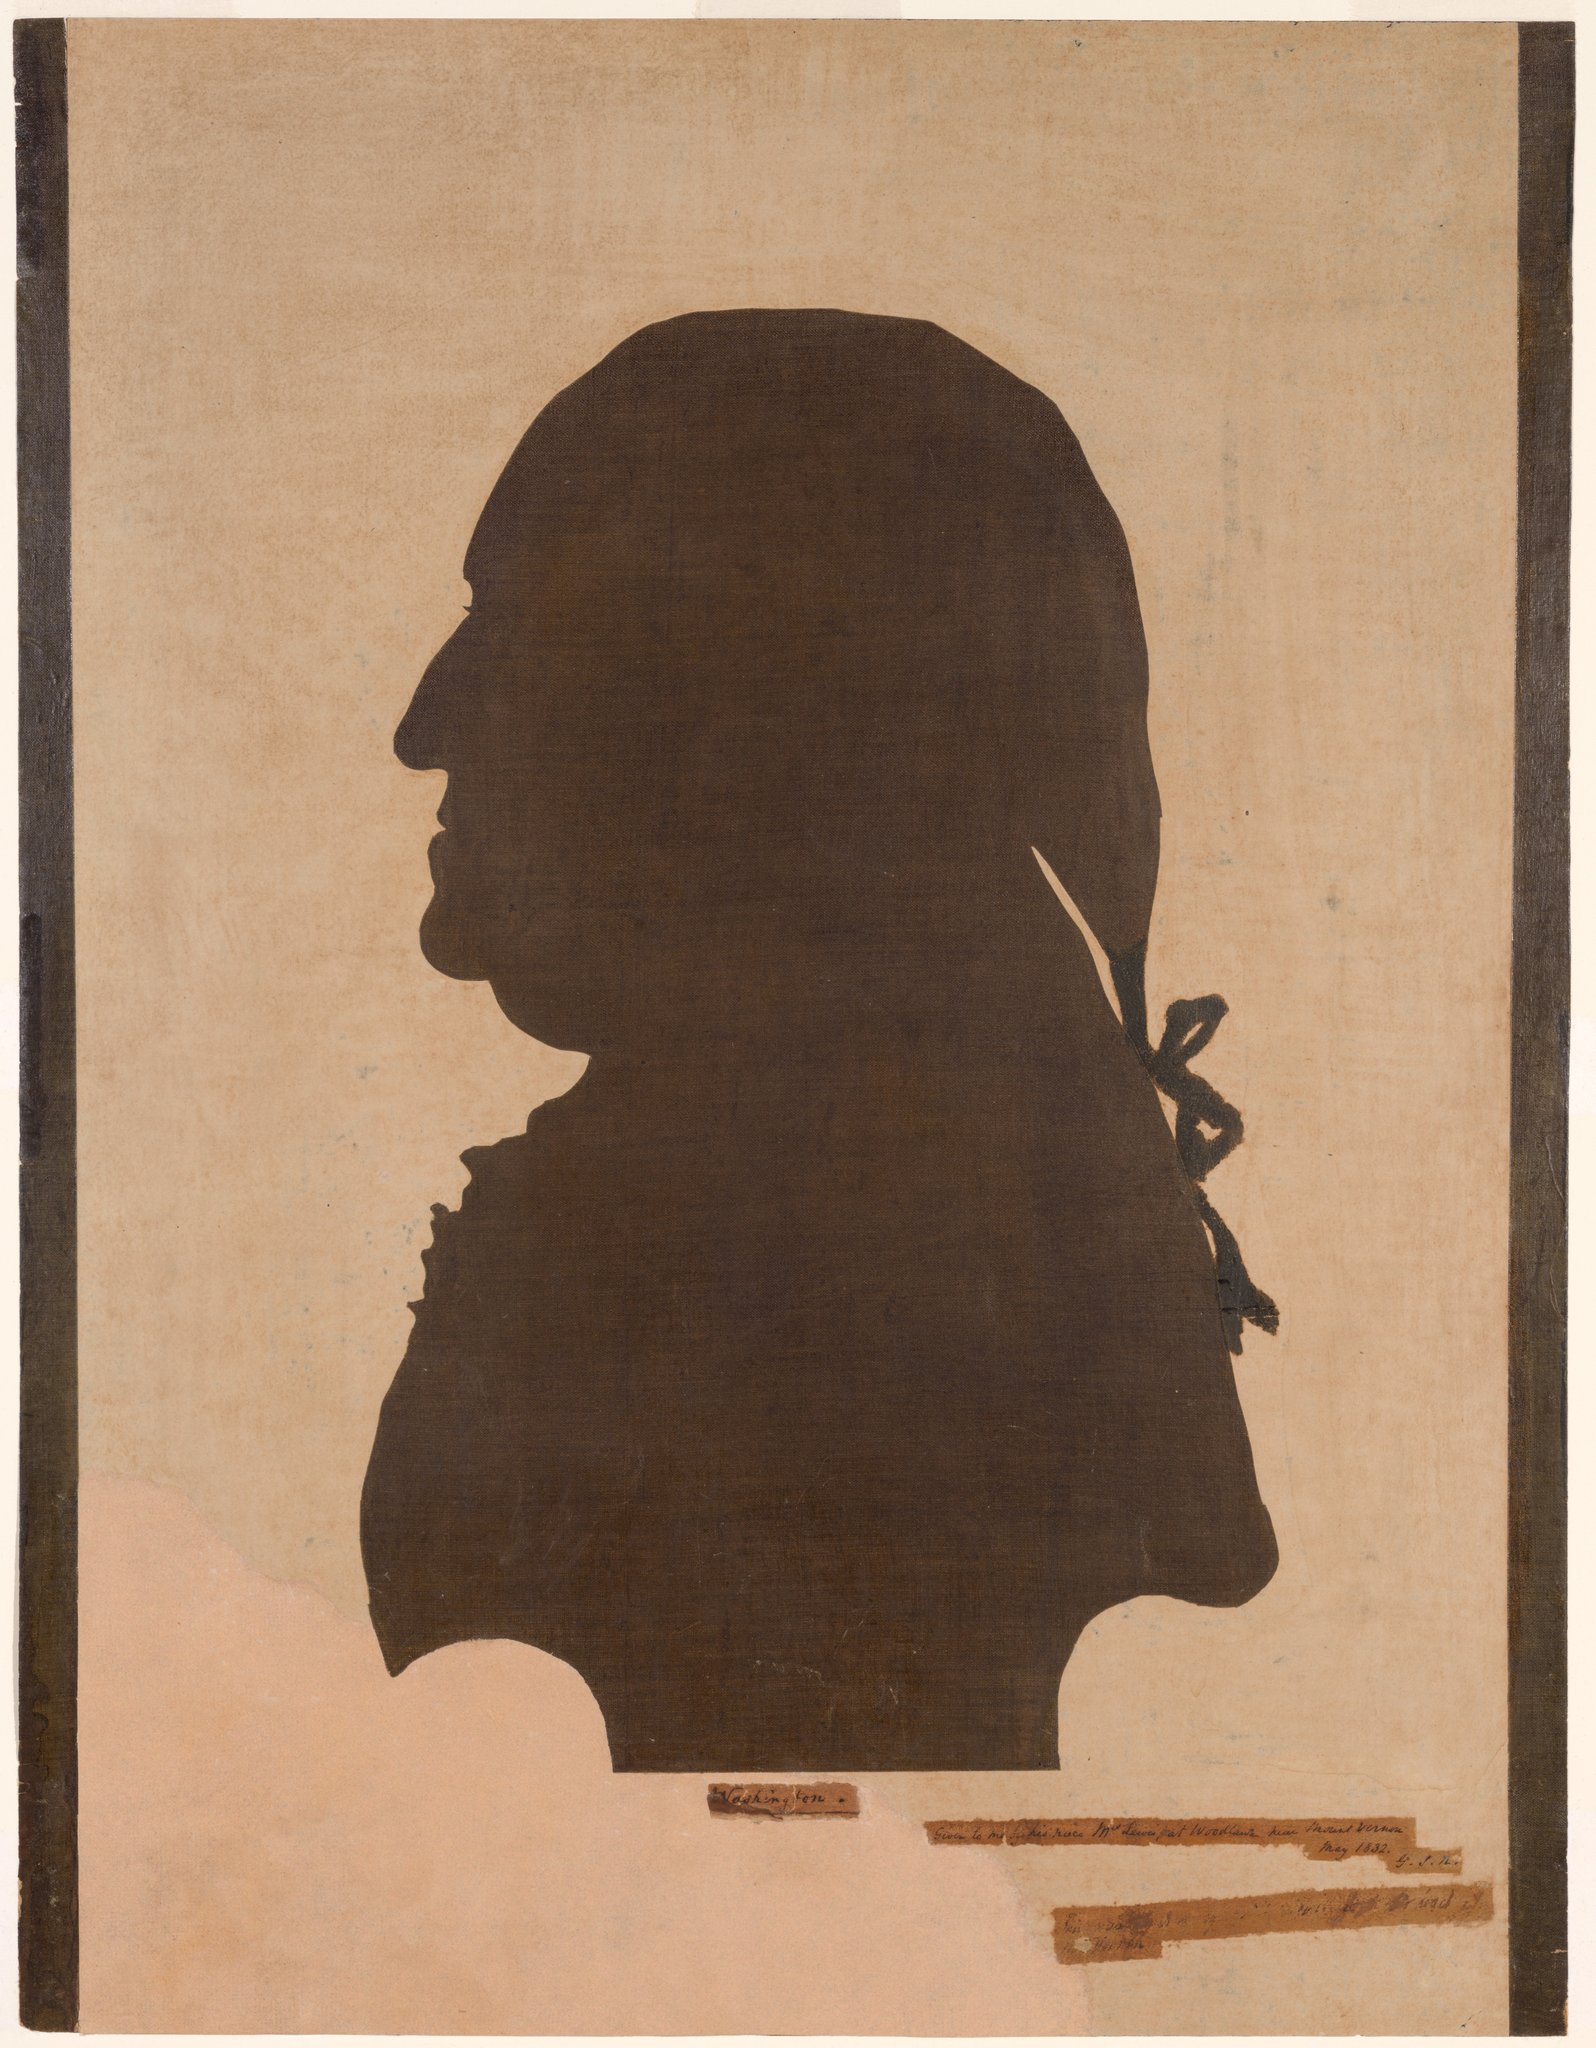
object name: silhouette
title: Portrait of George Washington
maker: eleanor parke custis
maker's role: artist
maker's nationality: american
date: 1798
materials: linen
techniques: cutting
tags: george washington,men,portraits,profiles,presidents